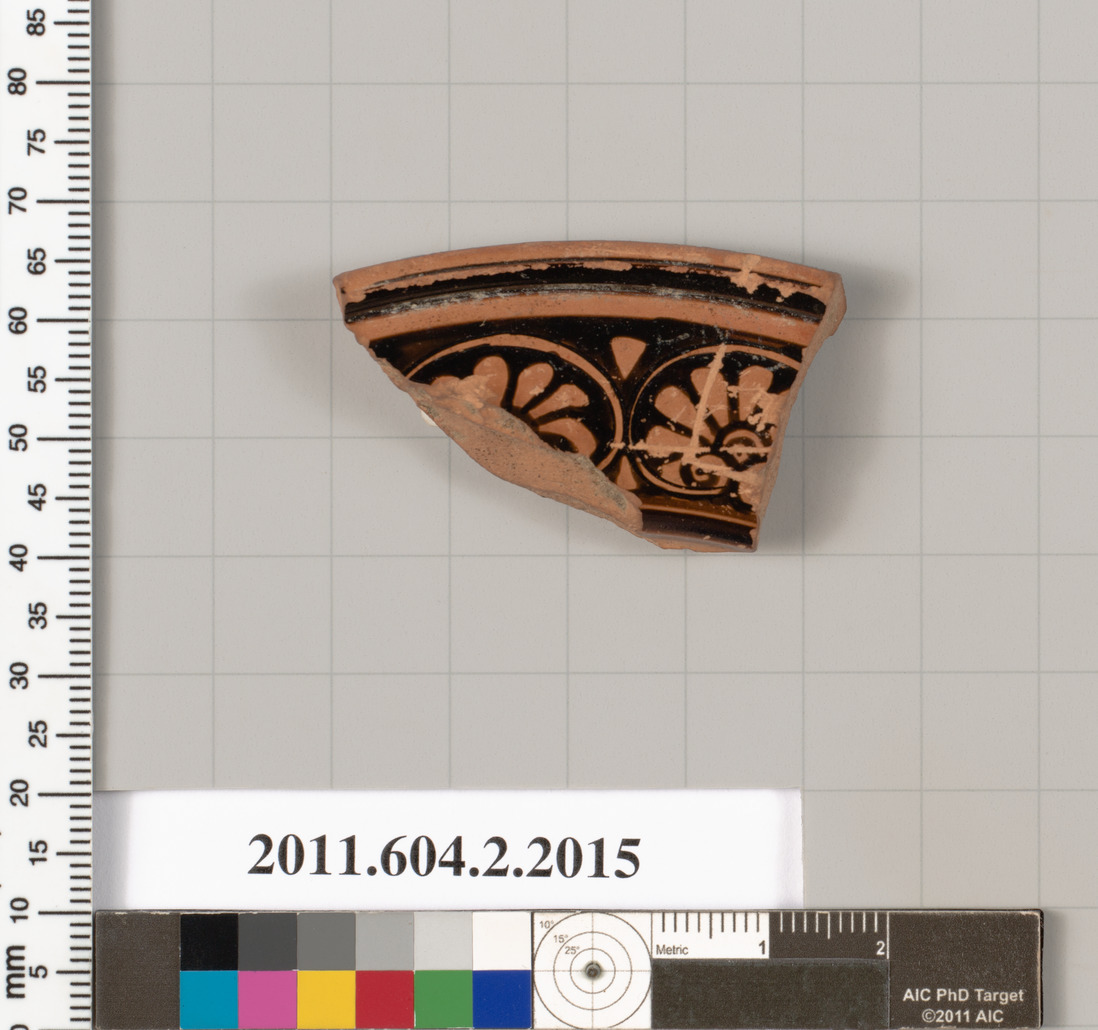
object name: plate fragment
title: Terracotta fragment of a plate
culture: greek, attic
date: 500 BCE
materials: terracotta